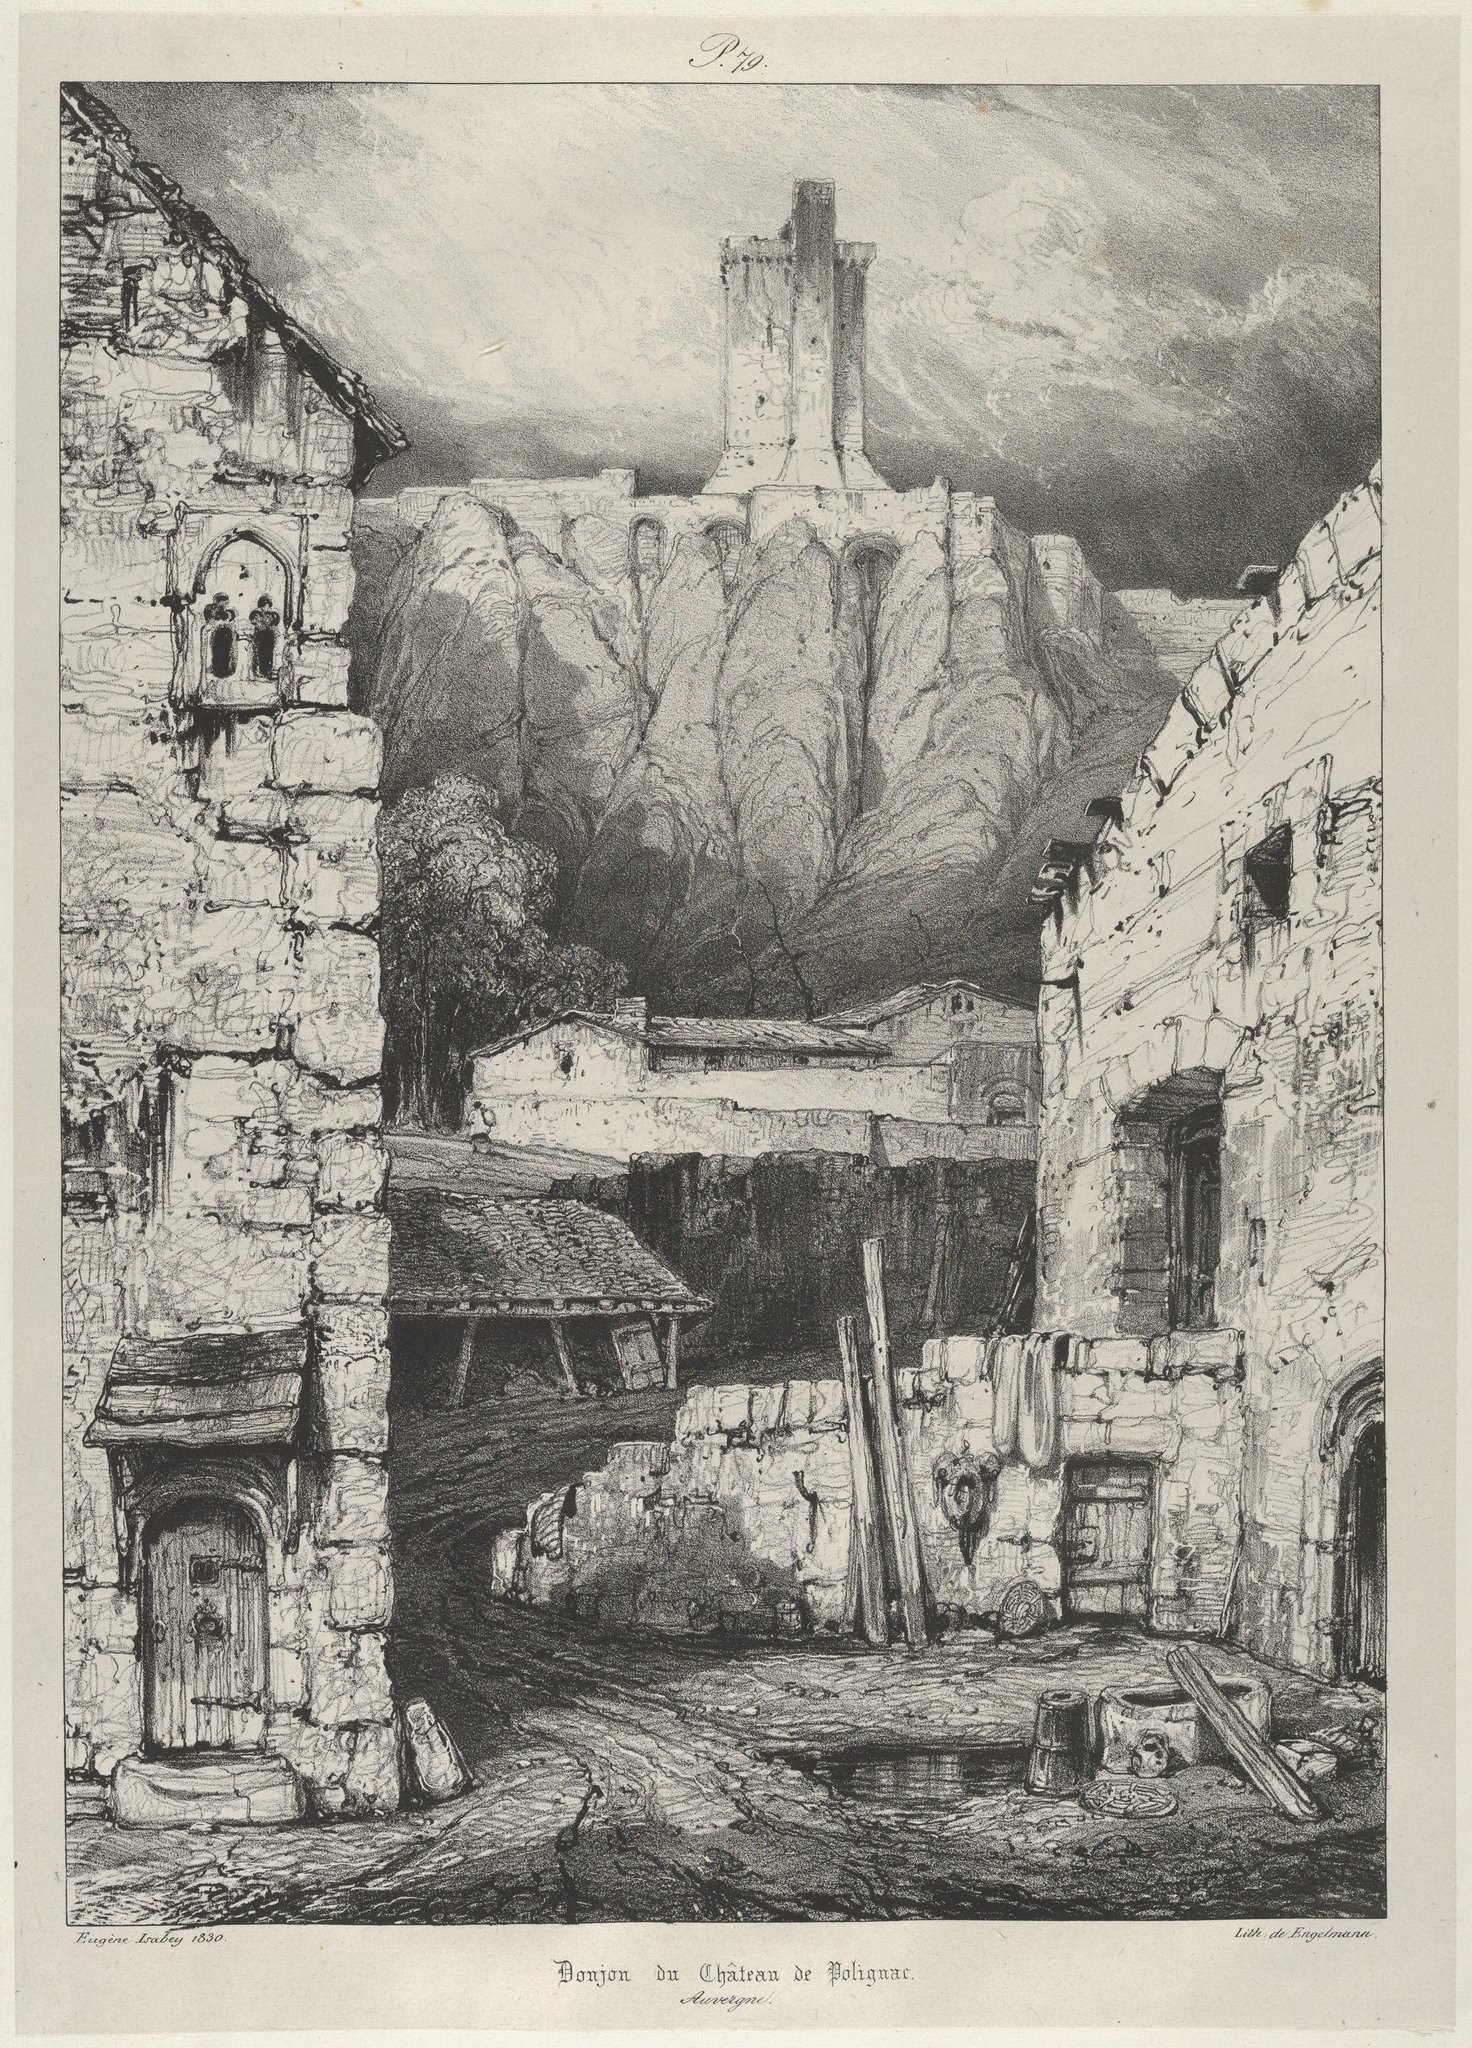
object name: print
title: Dungeon of the Polignac Castle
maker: eugène isabey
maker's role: artist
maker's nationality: french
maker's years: 1803-1886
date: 1830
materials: paper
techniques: printmaking, lithograph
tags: castles,prisons